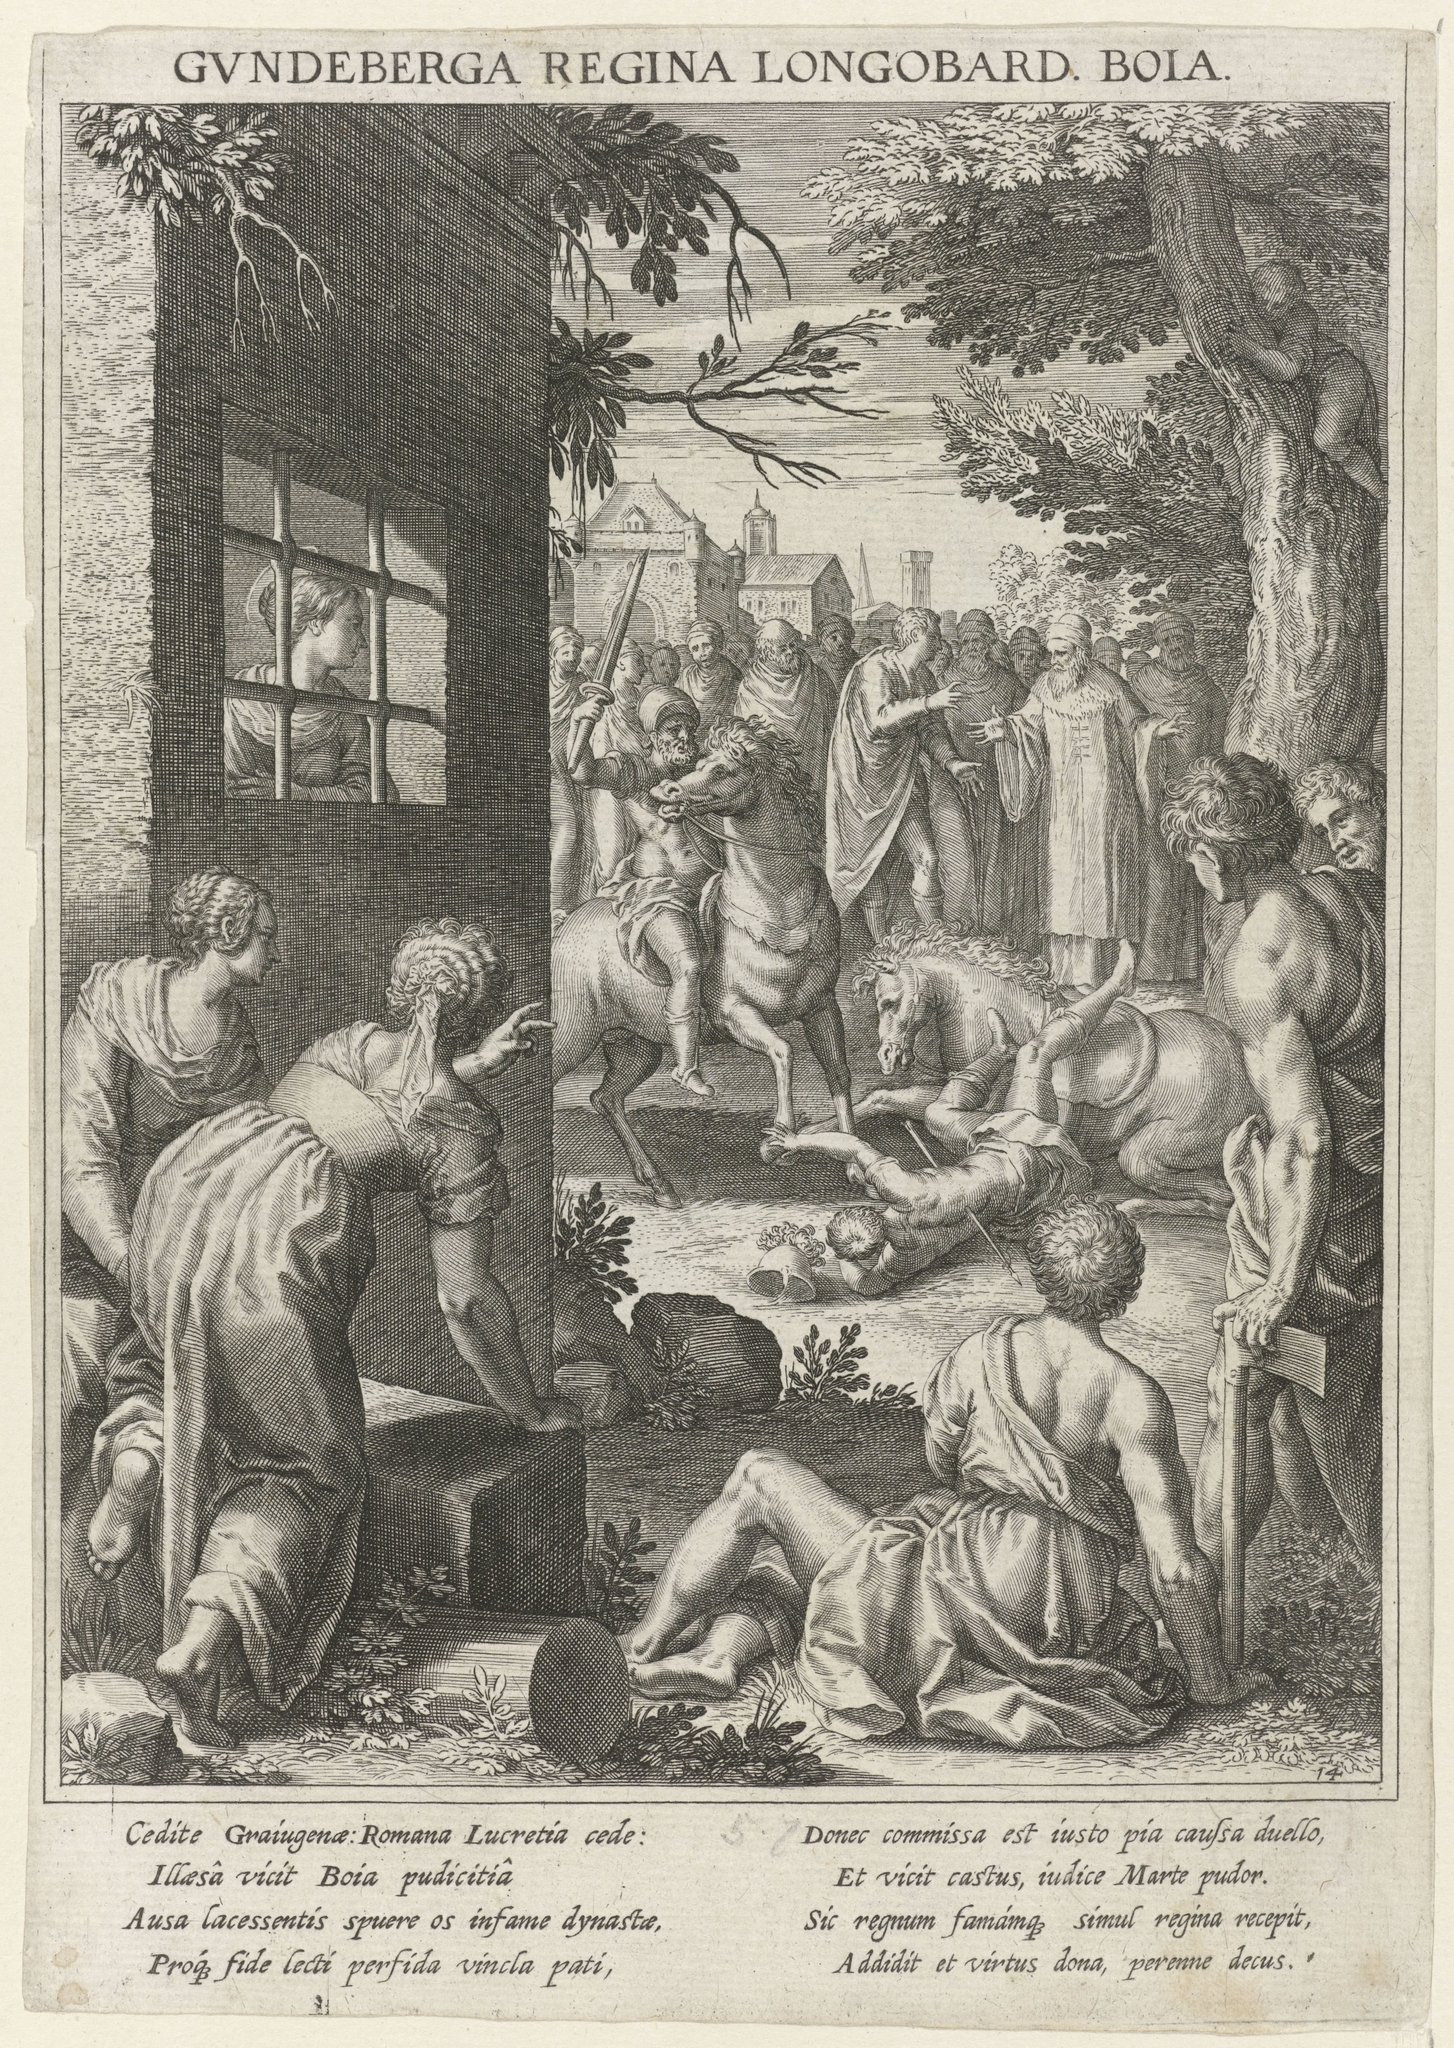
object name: print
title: Gundeberga, koningin van de Lombarden, kijkt naar het duel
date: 1615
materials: paper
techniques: engraving, etching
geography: munich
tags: prison, jail, judicial duel, historical persons - bb - woman, queen, empress, etc. (wife of a ruler)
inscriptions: collector's mark: Lugt 240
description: Gundeberga, koningin van de Lombarden, zit gevangen in een cel. Ze wordt beschuldigd van een moordpoging op haar man. Ze kijkt vanuit haar raam naar het duel tussen twee ridders dat haar lot zal bepalen. De prent heeft een Latijns onderschrift en is de veertiende prent van een 60-delige serie met als onderwerp de heiligen van Beieren.